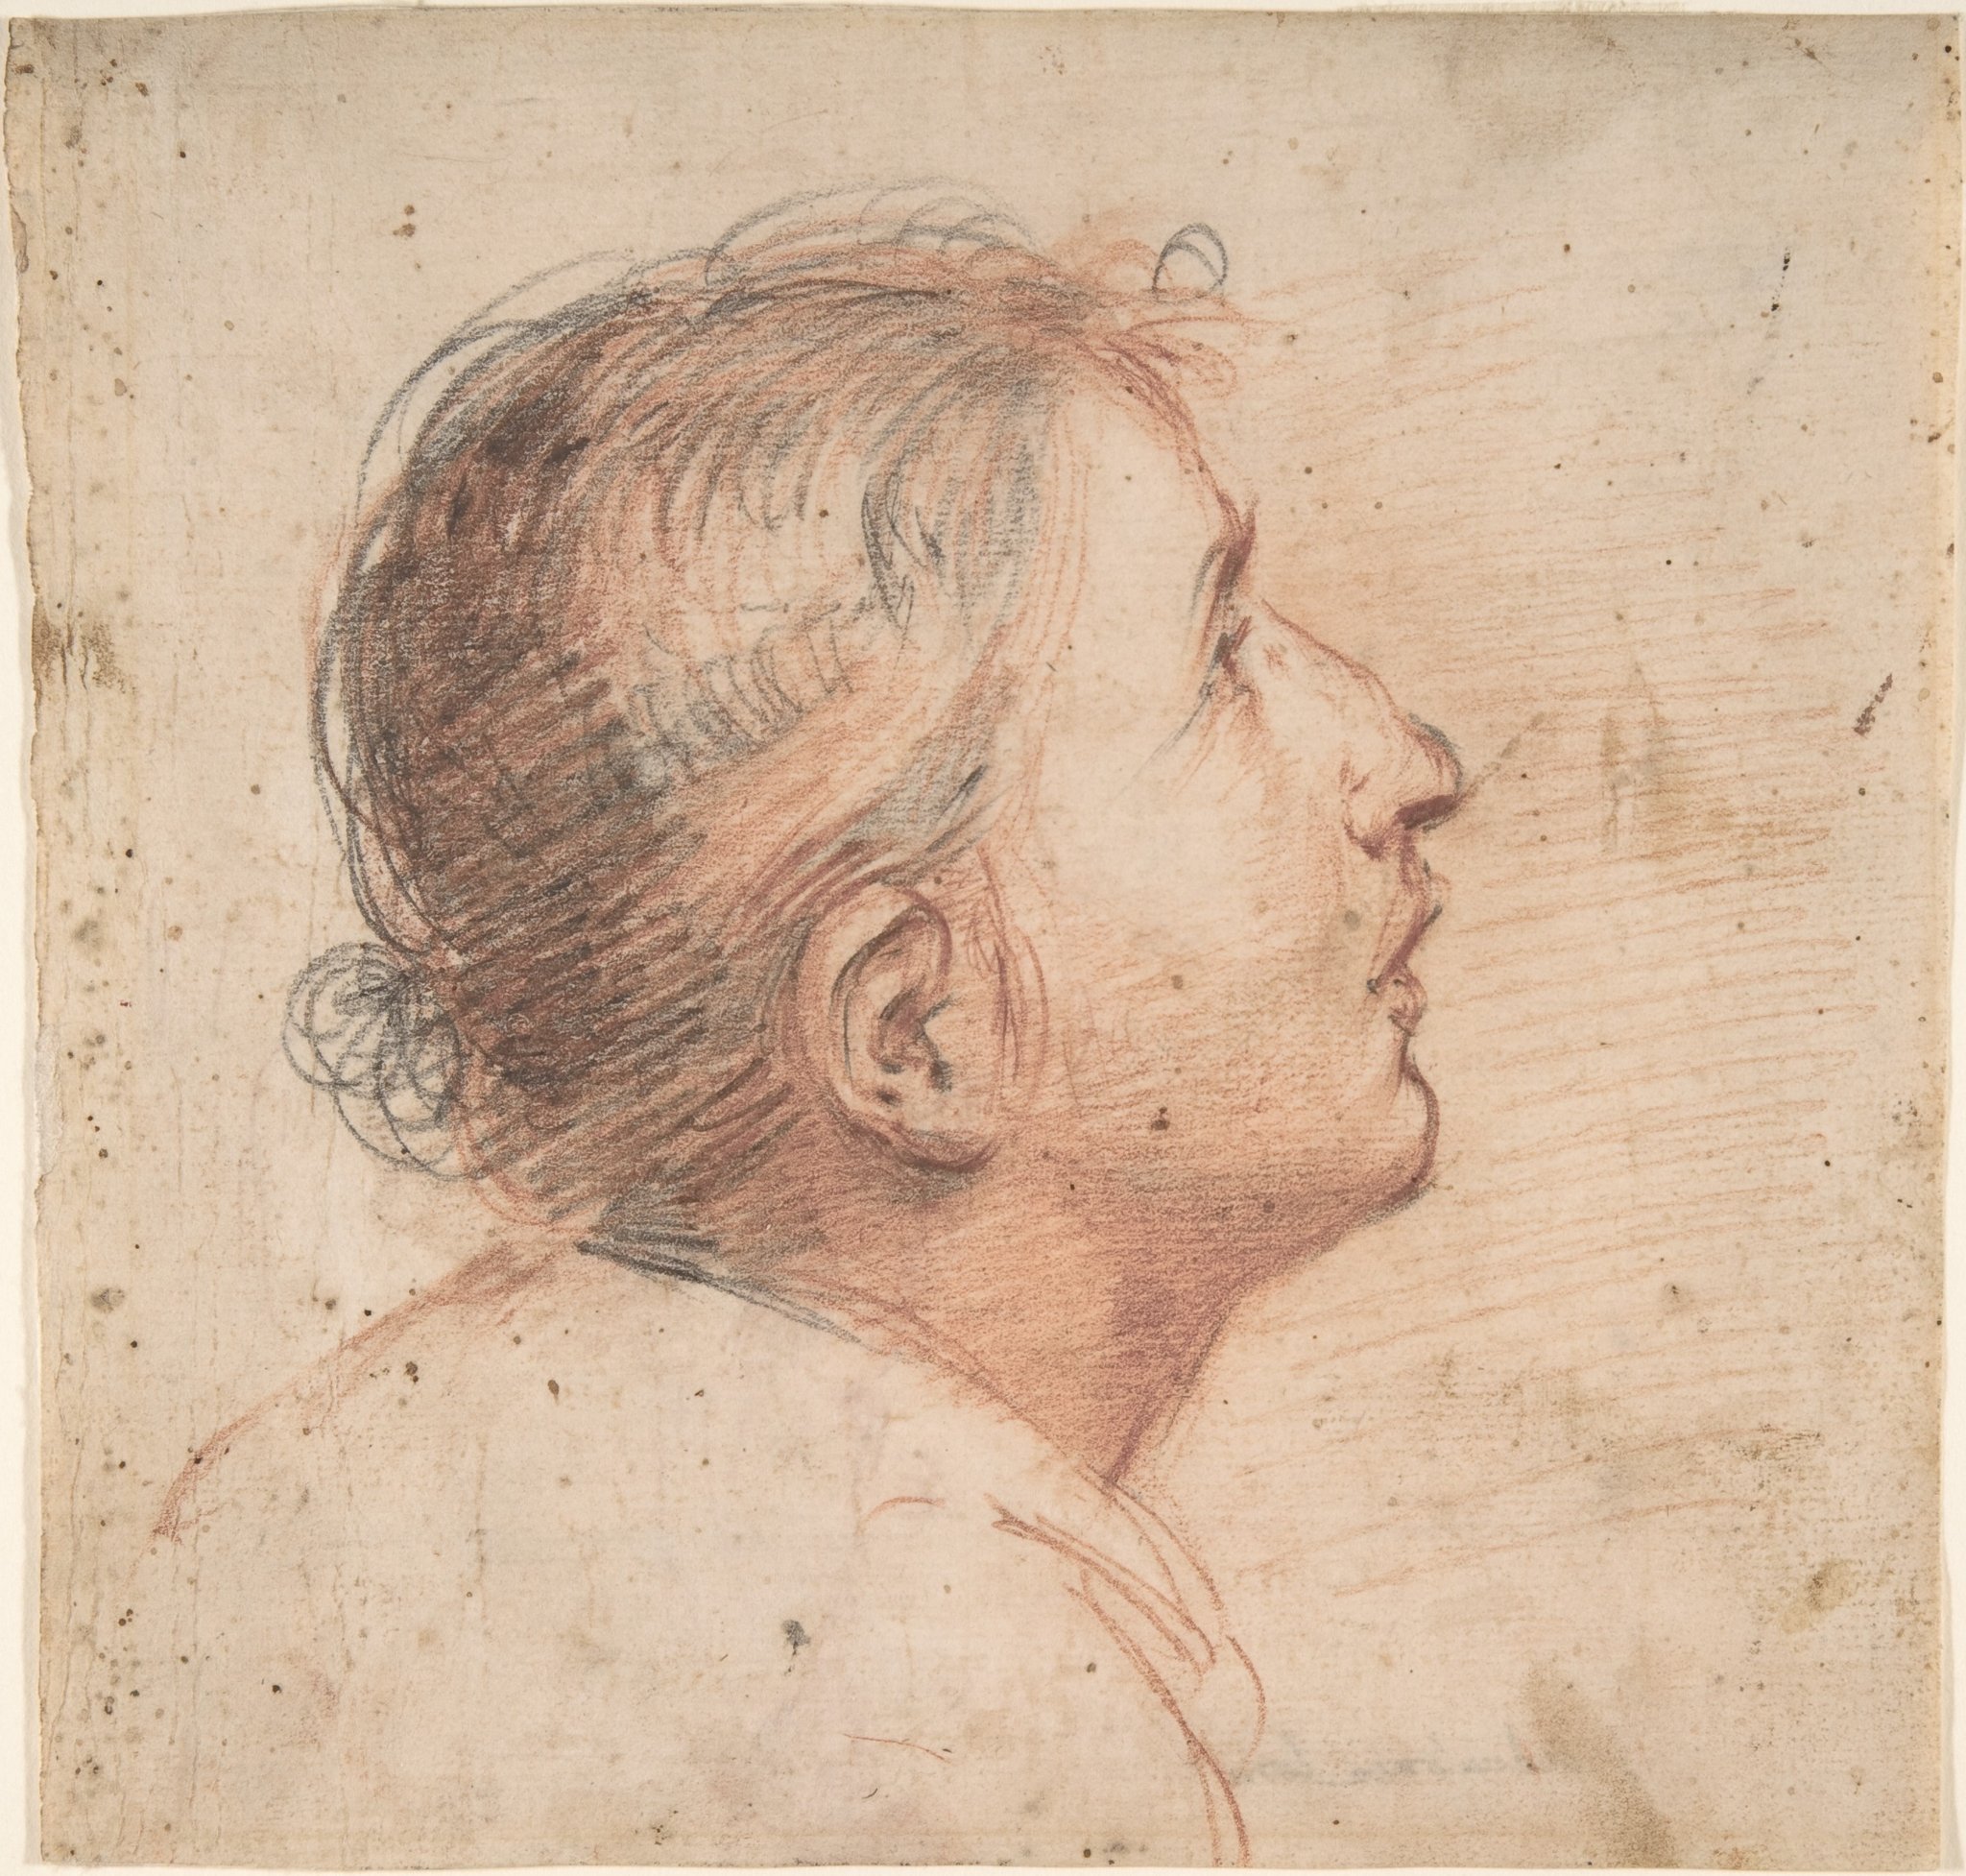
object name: drawing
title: Youth Gazing Upwards in Profile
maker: francesco montelatici ("cecco bravo")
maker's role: artist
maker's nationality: italian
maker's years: 1601-1661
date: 1607-1661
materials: chalk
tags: men,profiles